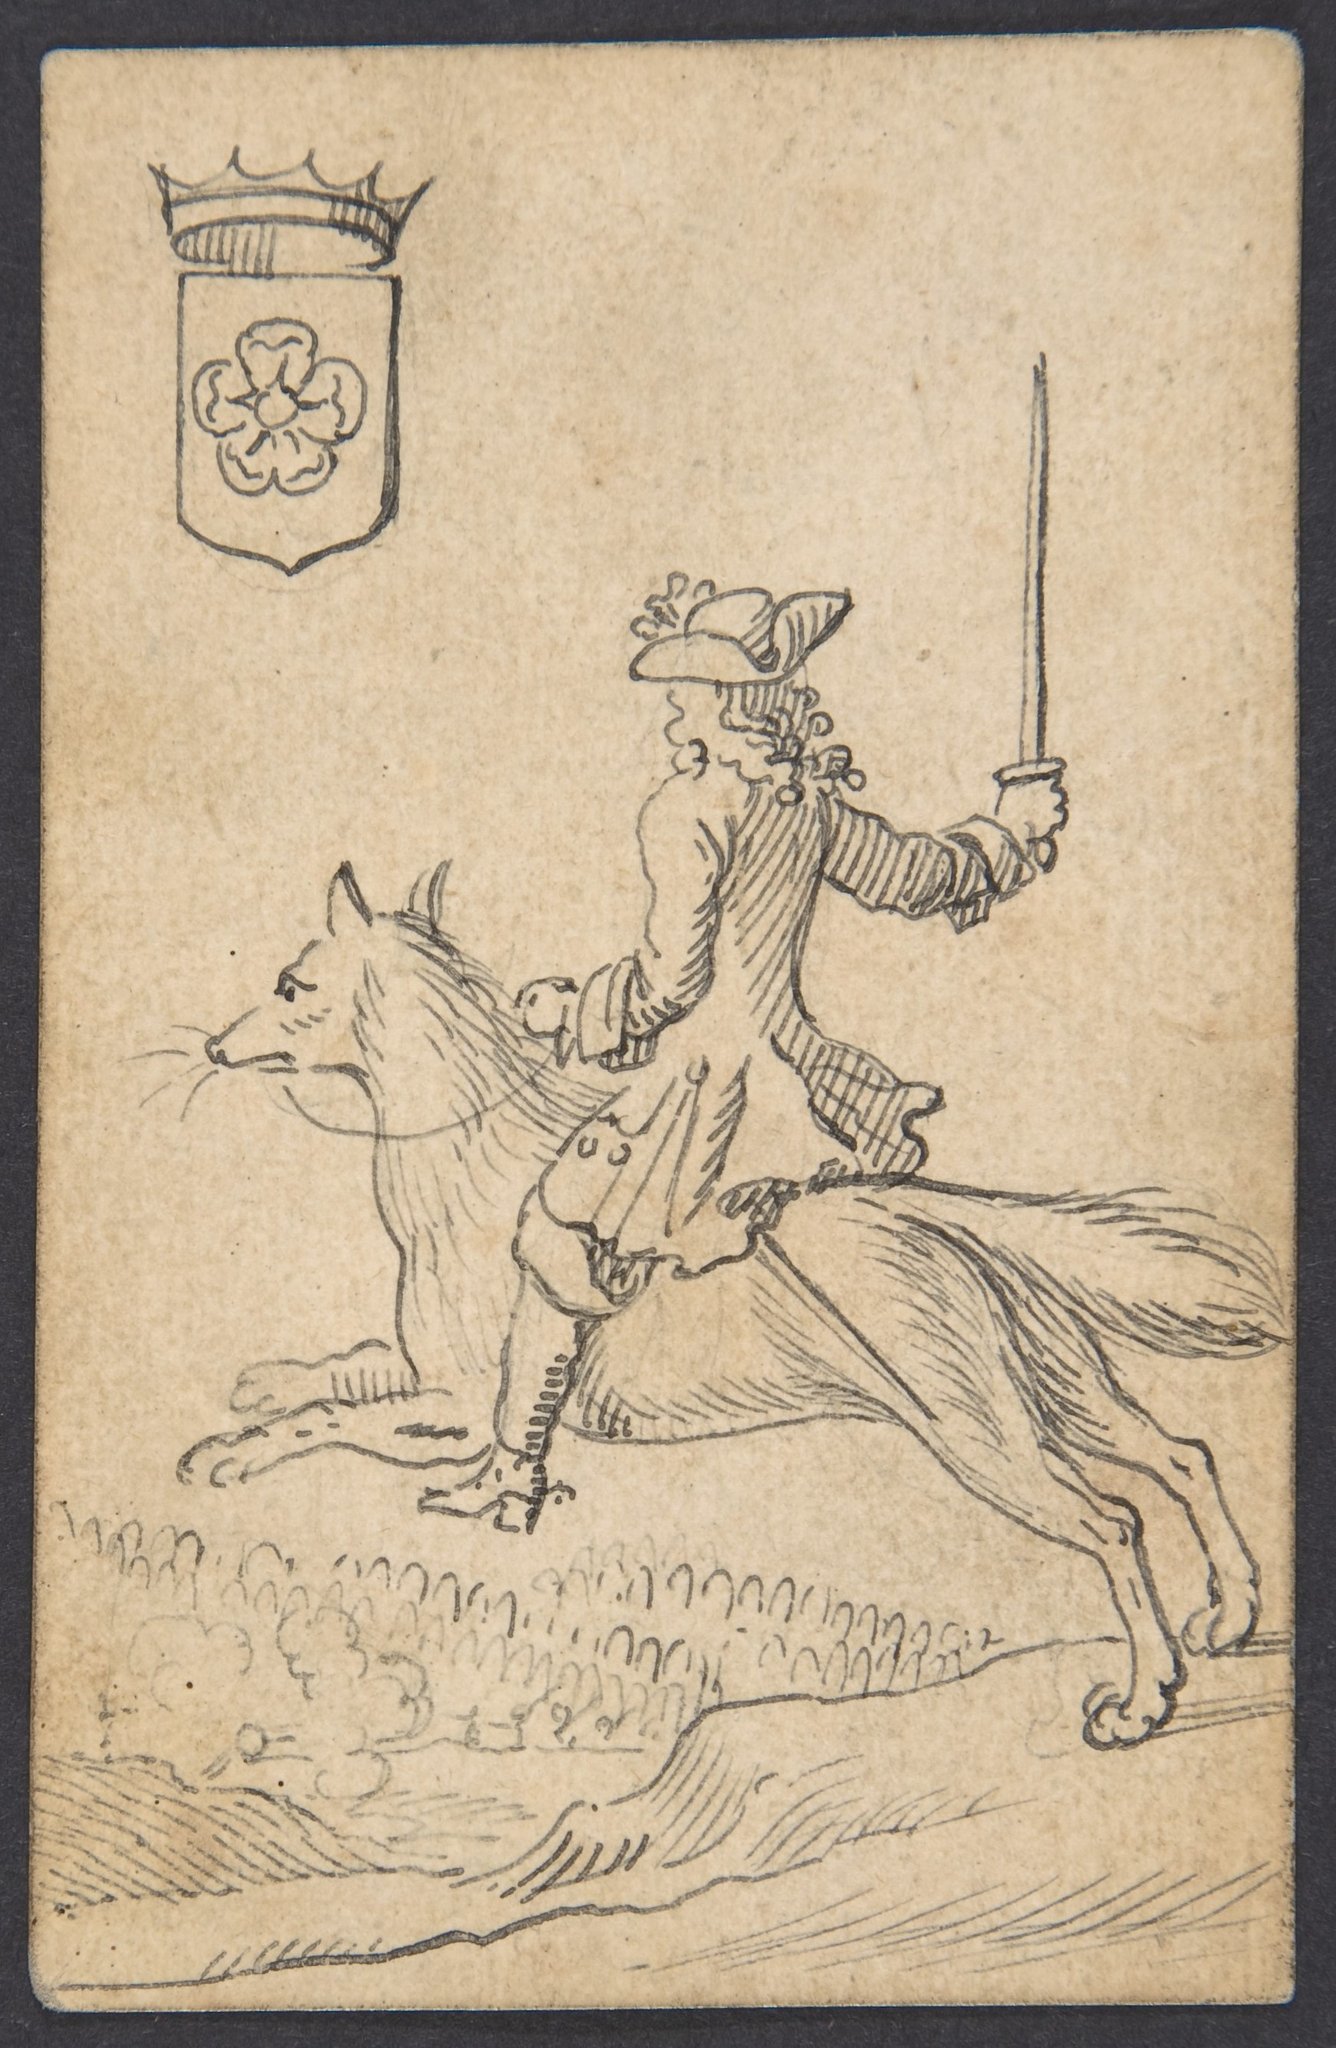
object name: drawing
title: Rose King: A Man Astride a Fox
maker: johannes brandenberg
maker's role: artist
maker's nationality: swiss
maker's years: 1661-1729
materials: ink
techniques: pen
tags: men,foxes